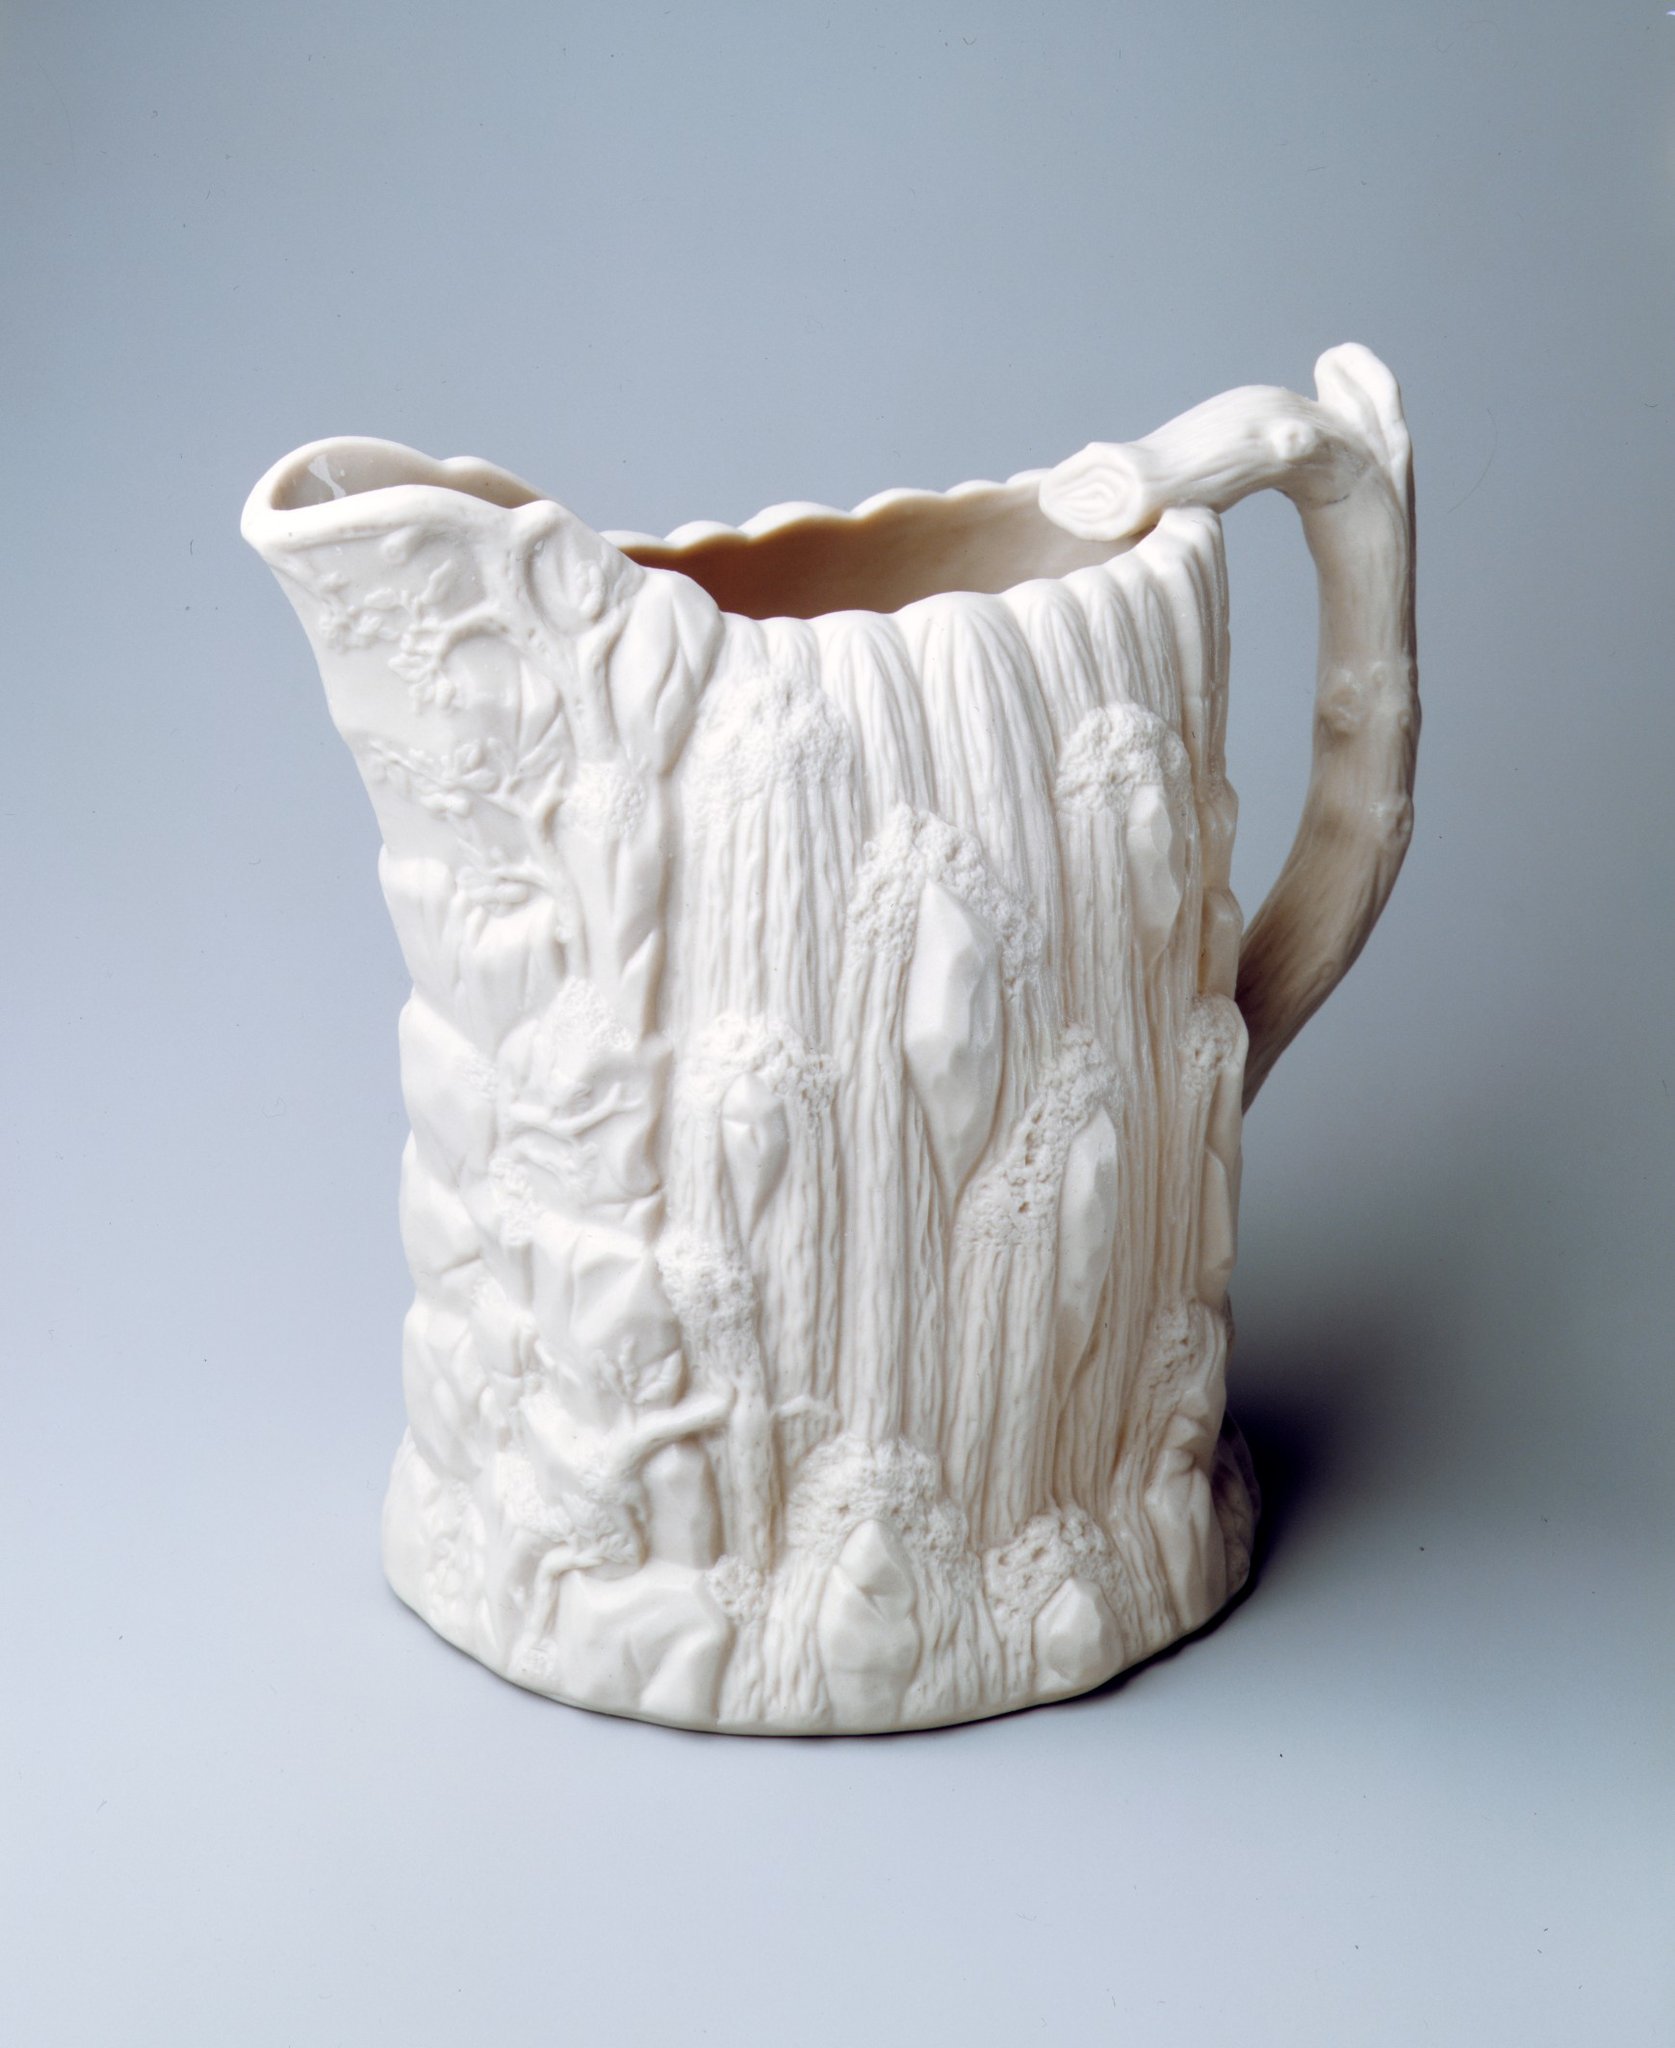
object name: pitcher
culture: american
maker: united states pottery company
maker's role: maker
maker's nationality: american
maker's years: 1852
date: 1852-1858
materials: porcelain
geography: united states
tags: waterfalls